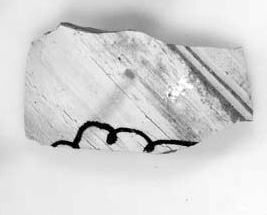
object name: shard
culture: korean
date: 1401-1500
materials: pottery